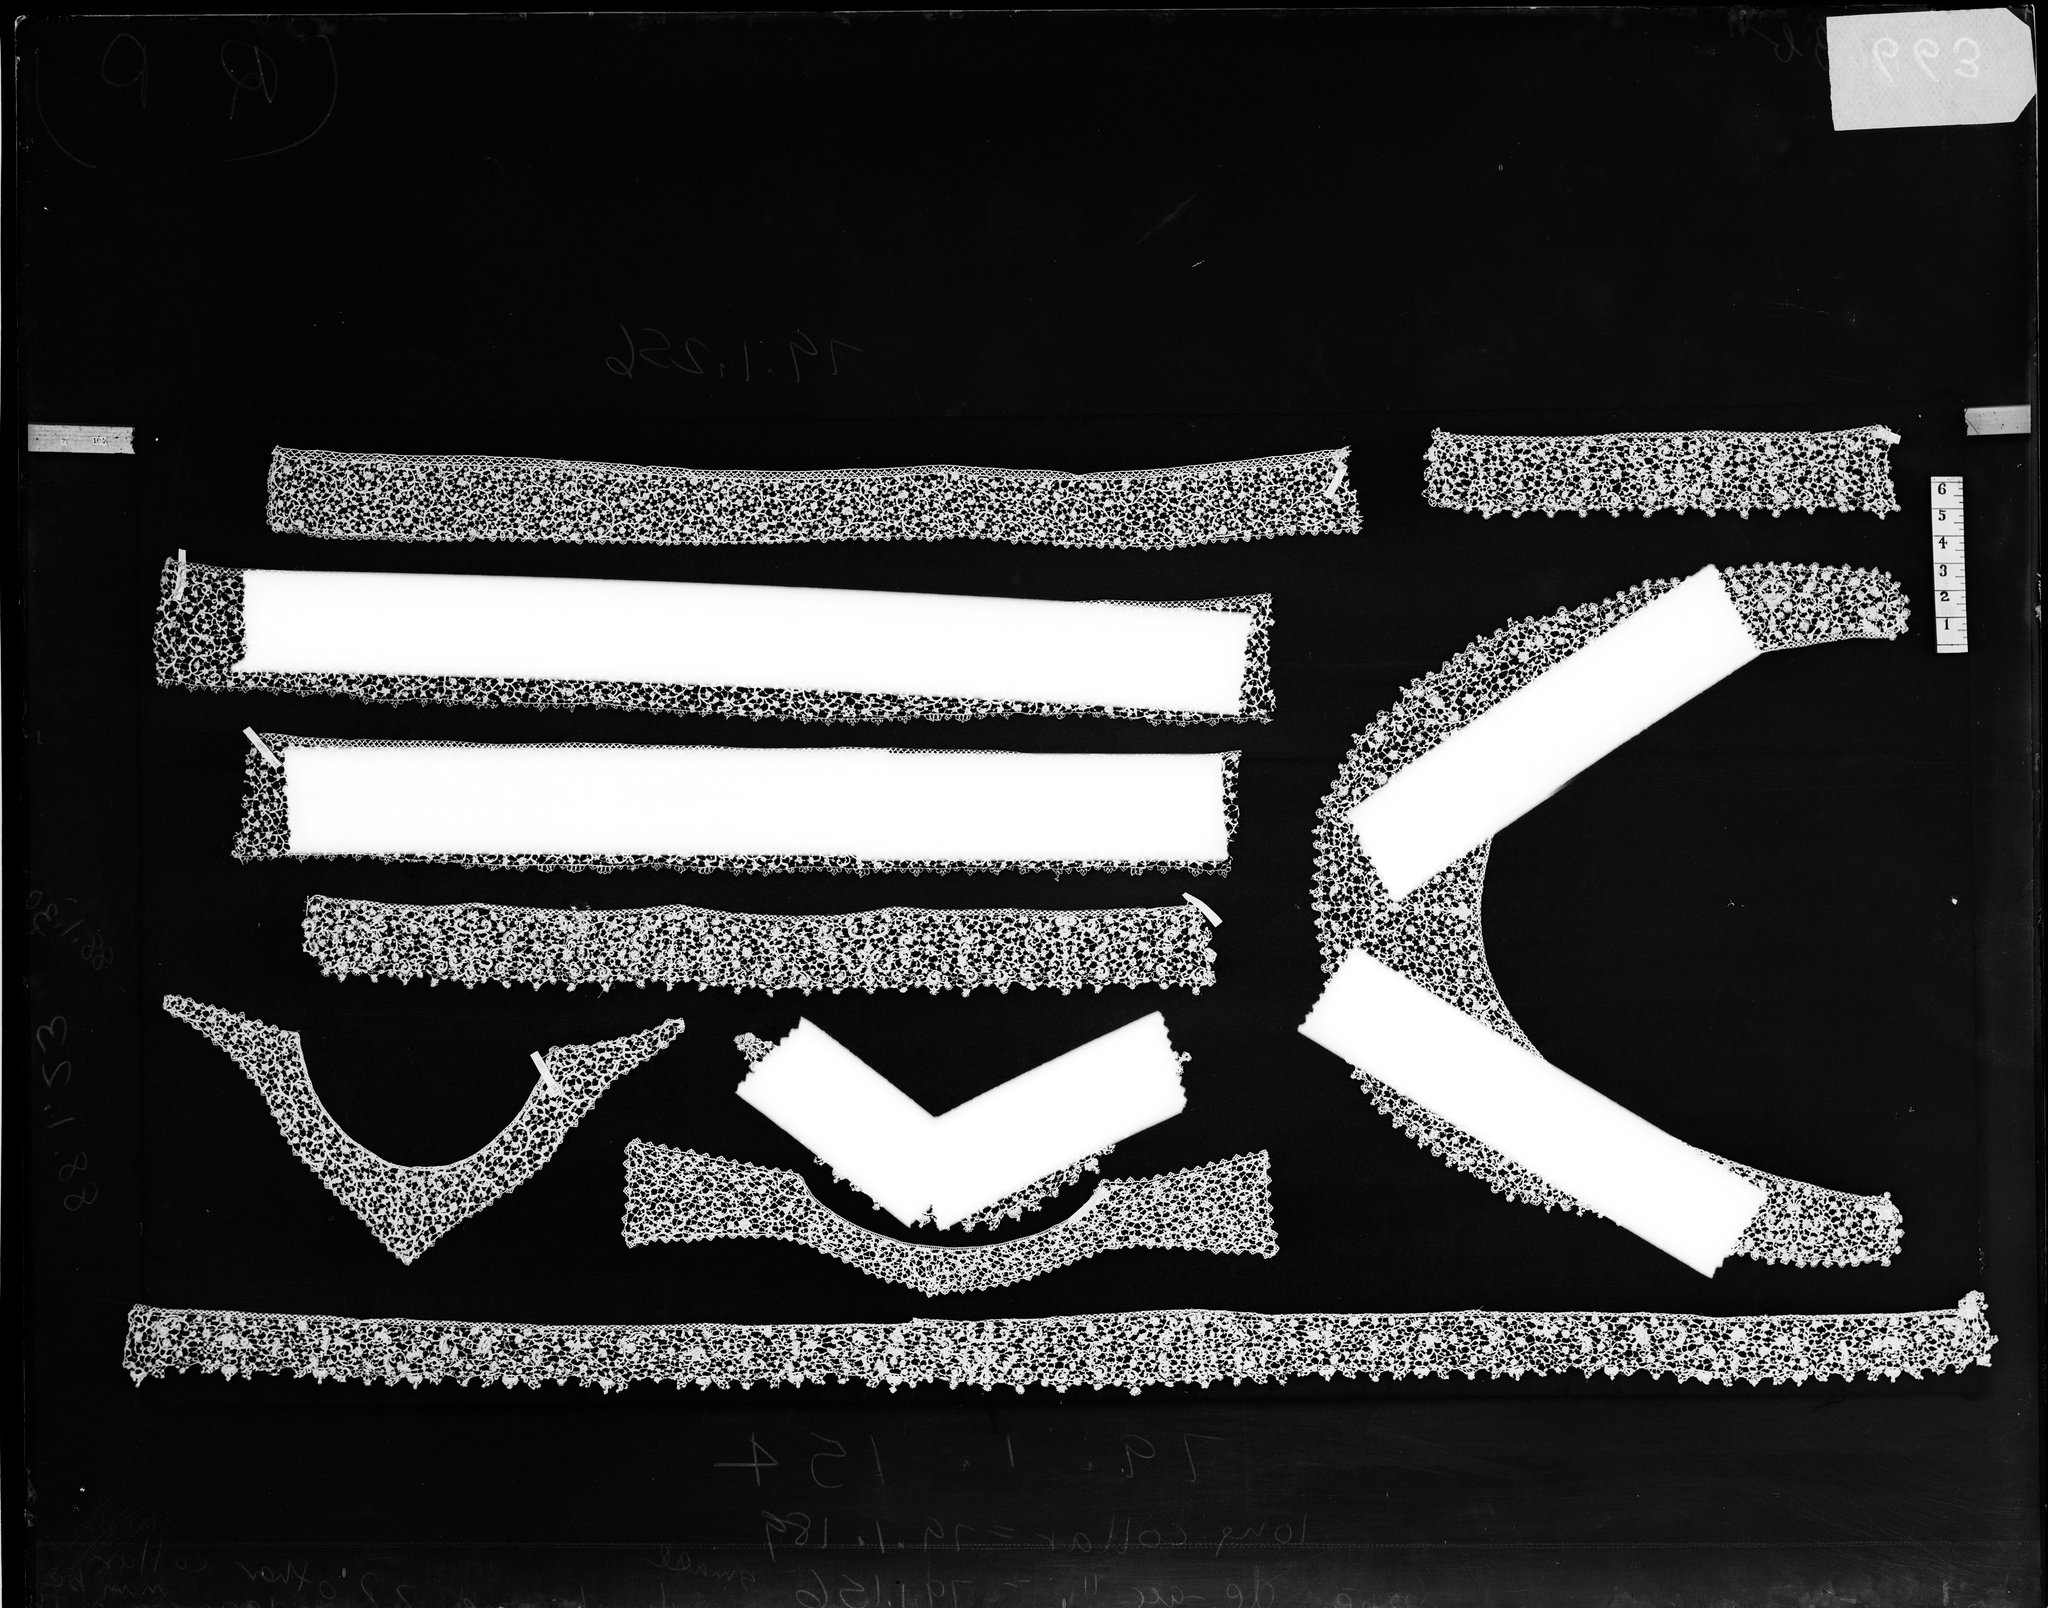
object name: strip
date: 1701-1800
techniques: lace